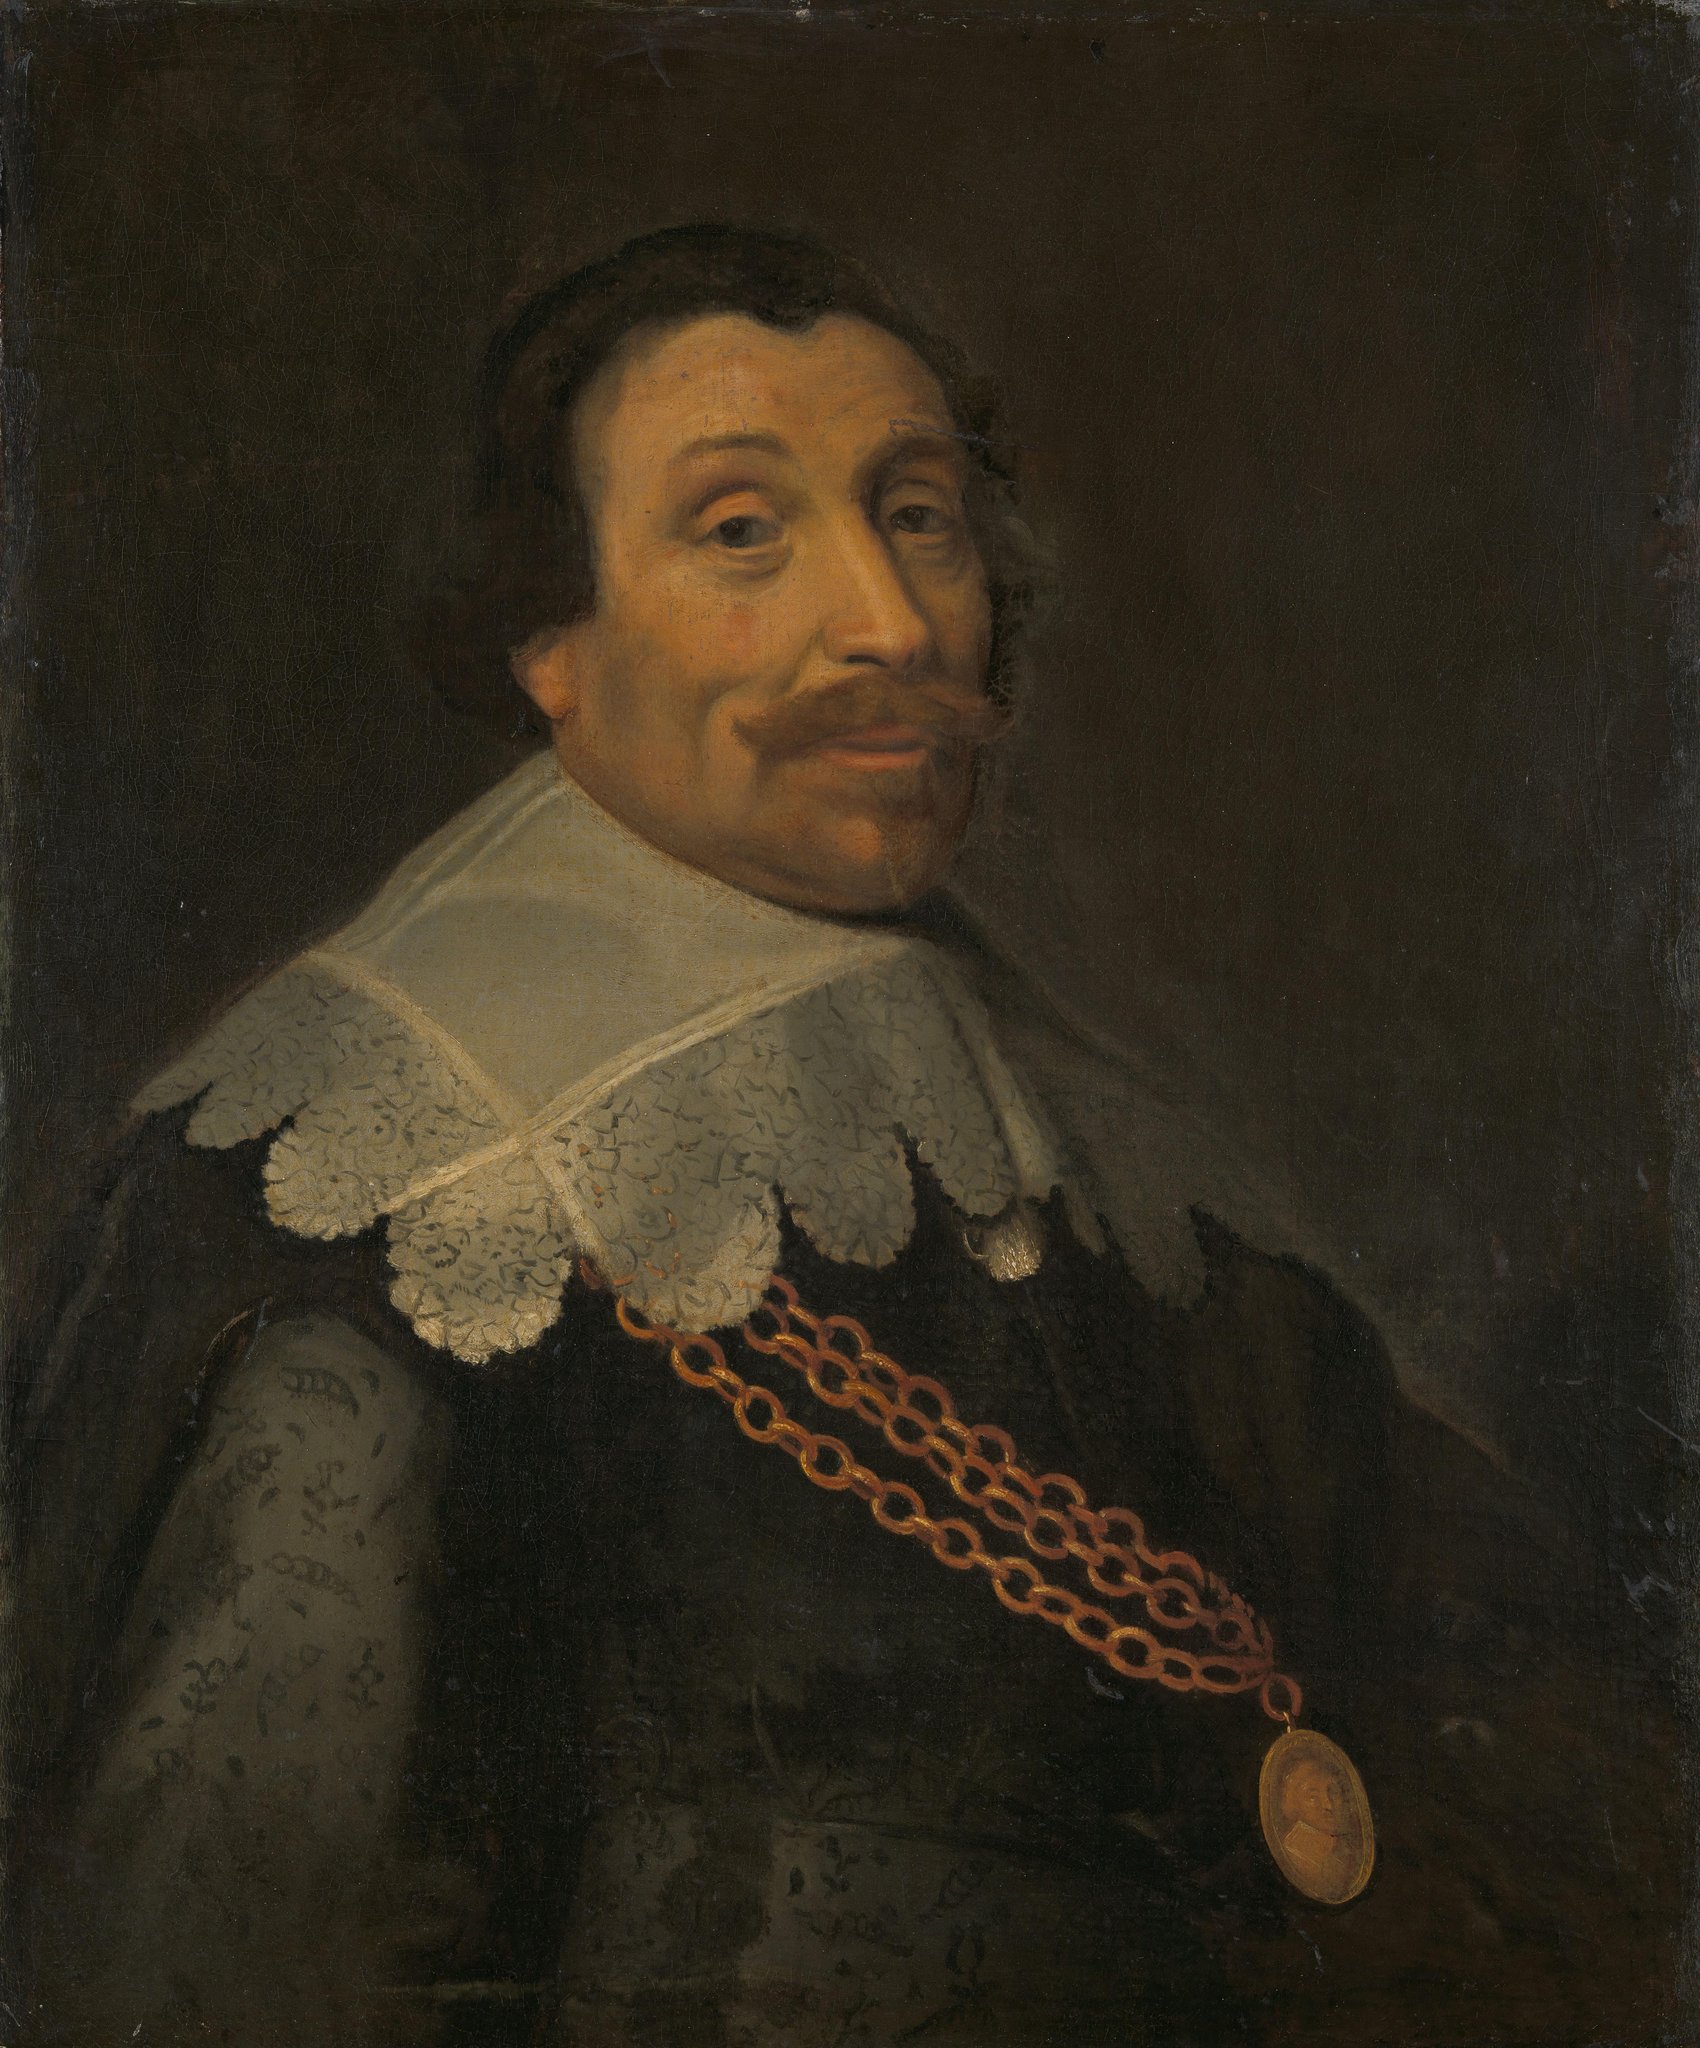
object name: painting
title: Portrait of Maerten Harpertsz Tromp (1598-1653)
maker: michiel jansz van mierevelt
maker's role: draughtsman, painter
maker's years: 1567-1641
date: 1640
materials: canvas, oil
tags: brielle, maarten harpertszoon tromp, historical persons, commander-in-chief, admiral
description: Maarten Harpertsz Tromp. Studio of M.J. van Miereveld, after an original of 1640. Admiral Maarten Harpertsz Tromp (1598-1653) was born into a seafaring family. In 1607, at the age of nine, he was on board his father's ship at the Battle of Gibraltar, fighting the Spanish fleet. He was to rise to the highest rank in the navy. In 1639 he inflicted a crucial defeat on Spain at the Battle of the Downs off the southeast coast of England. In 1652 Tromp was given command of the Dutch navy. That year, four years after peace had been signed with Spain, tension with England eventually led to war. Tromp was killed in 1653 in the Battle of Ter Heijde off the coast of South Holland which was won by the English.